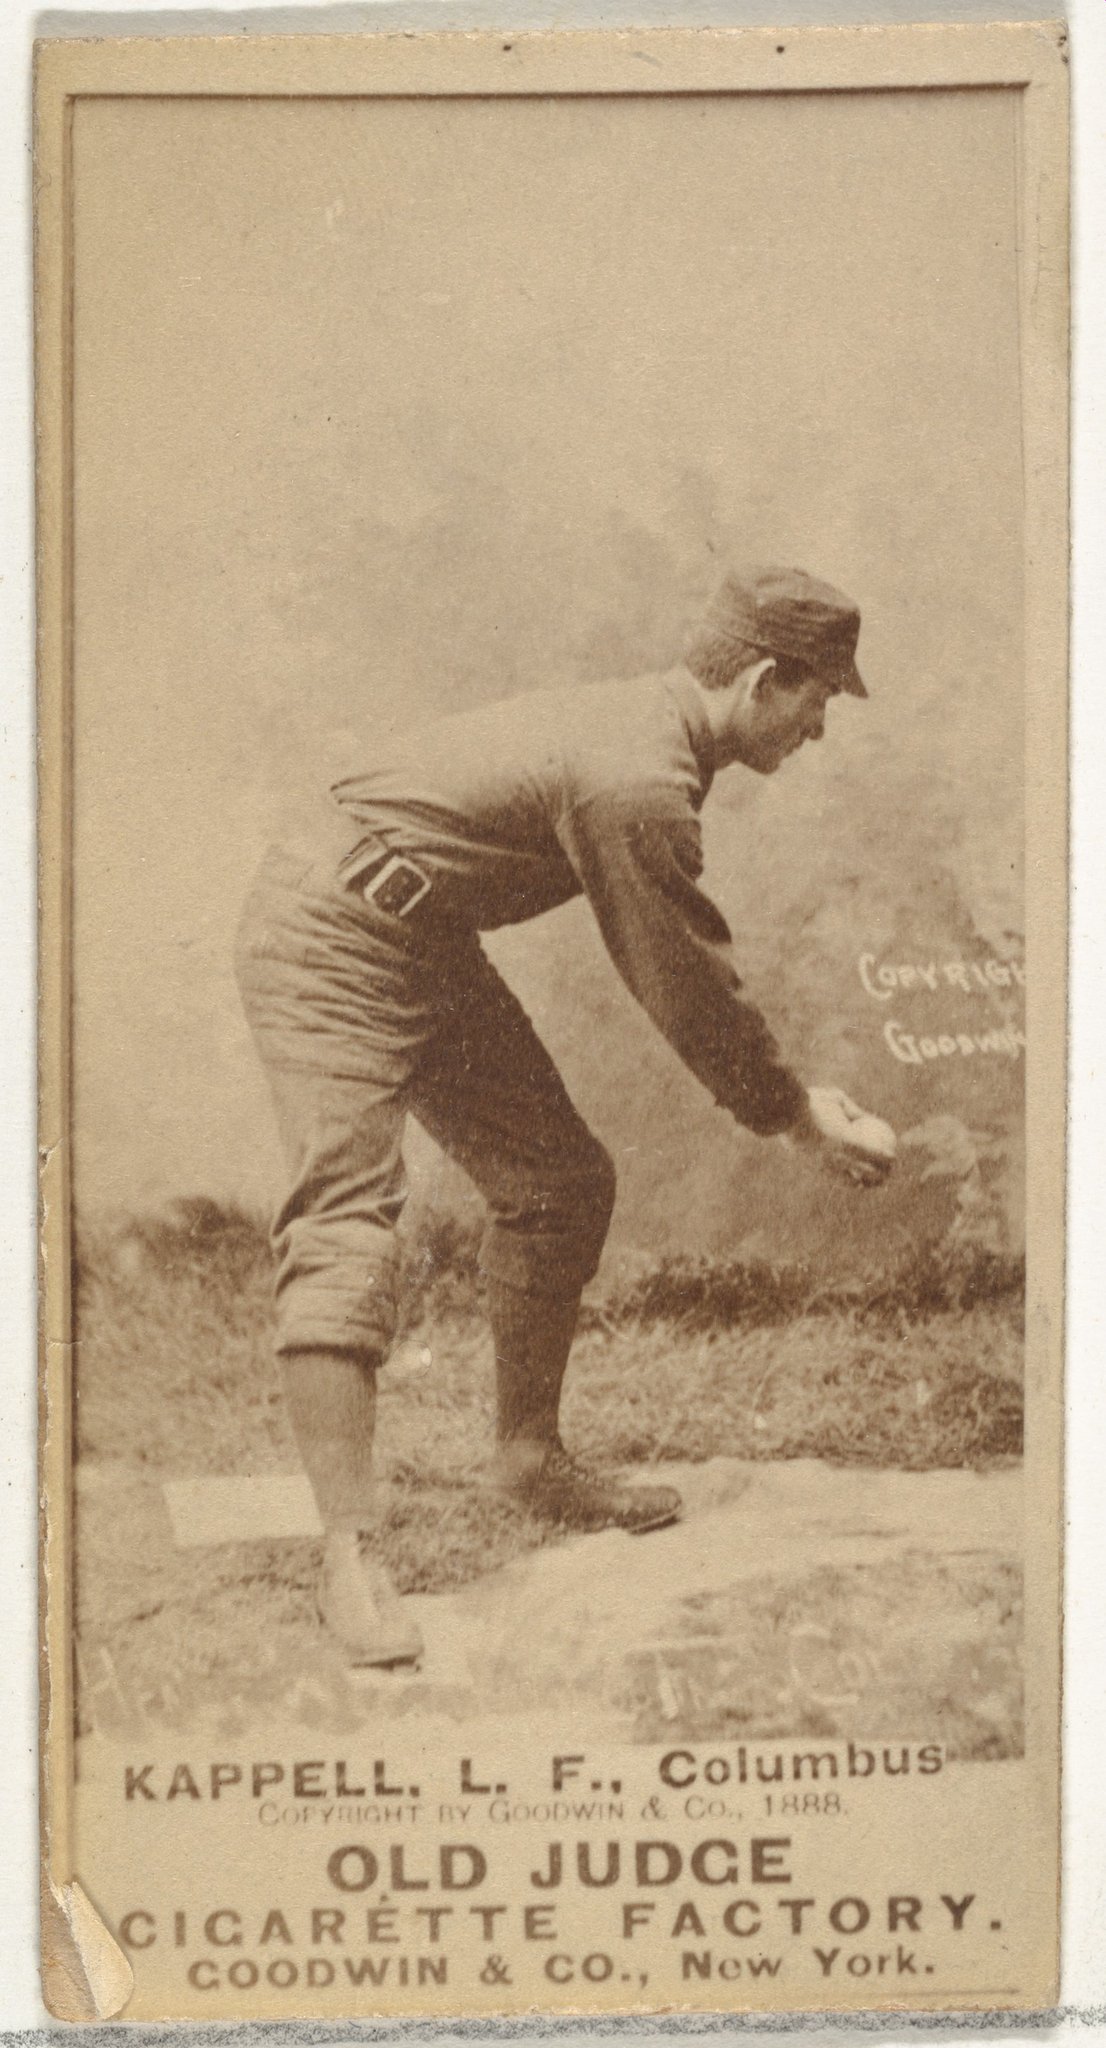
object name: baseball card, photograph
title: Henry "Heinie" Kappel, Left Field, Cleveland, from the Old Judge series (N172) for Old Judge Cigarettes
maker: goodwin & company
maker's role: publisher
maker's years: 1850-1950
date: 1888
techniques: albumen silver print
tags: men,profiles,baseball,athletes